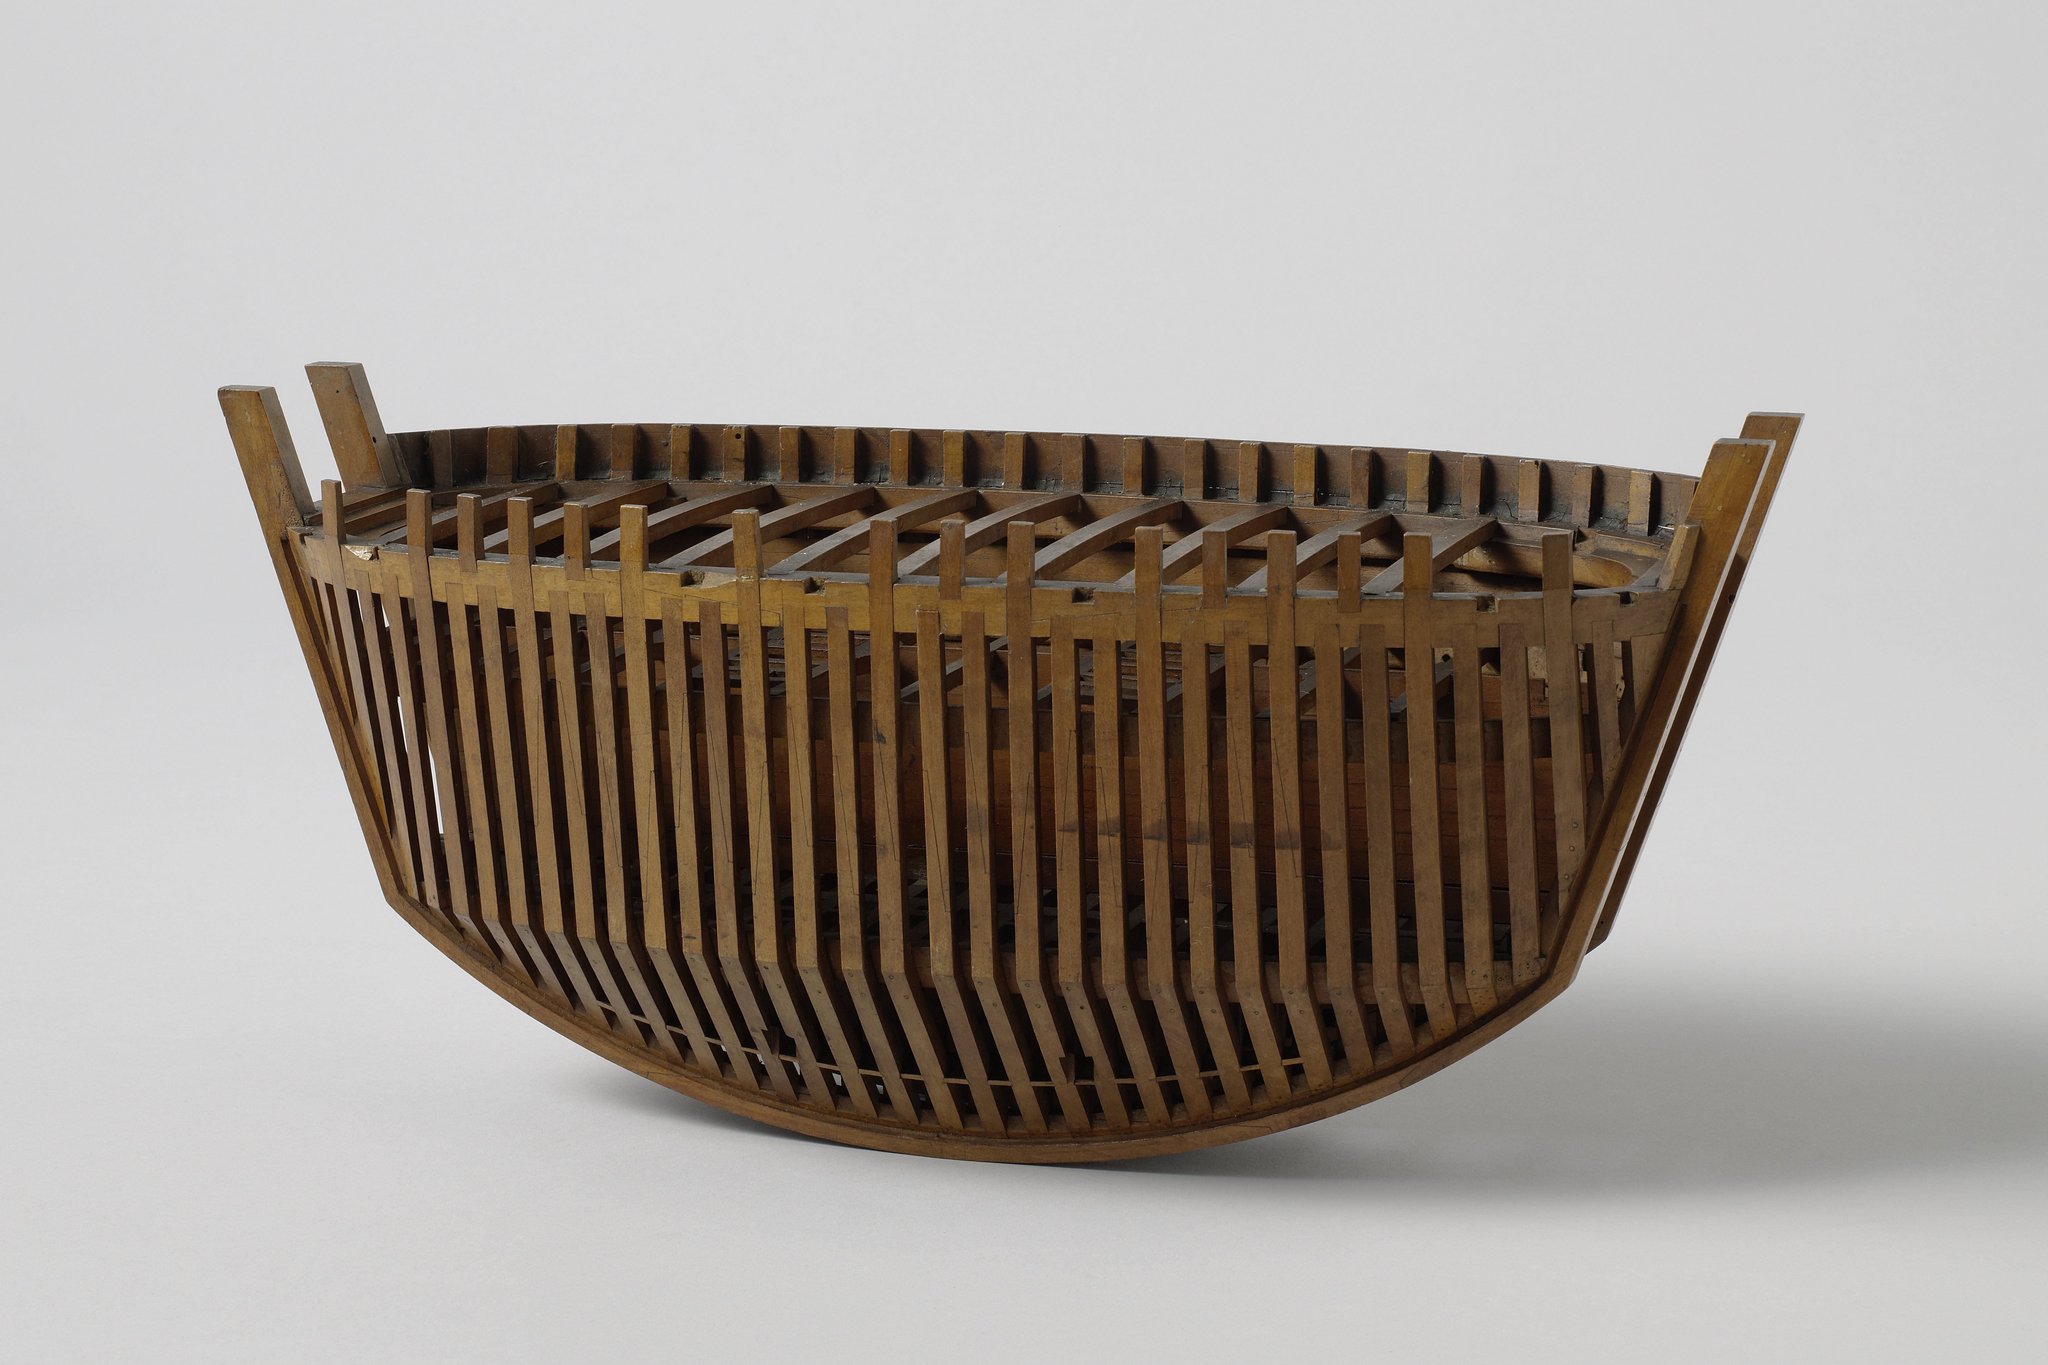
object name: demonstration model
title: Model of a Caisson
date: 1800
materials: brass, wood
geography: france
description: Spantmodel van een schipdeur met dubbele kiel, incompleet. Aan de ene zijde is de schipdeur geheel afgewerkt, de andere kant is open. Drie dekken, en in de lengte in twee compartimenten ingedeeld. Twee kleine spuigaten onder aan de gesloten zijde, de afsluiters ontbreken. Er zijn uitsparingen voor slechts één pomp aan iedere kant. Het model lijkt veel op NG-MC-991 en past in diens sponningen.